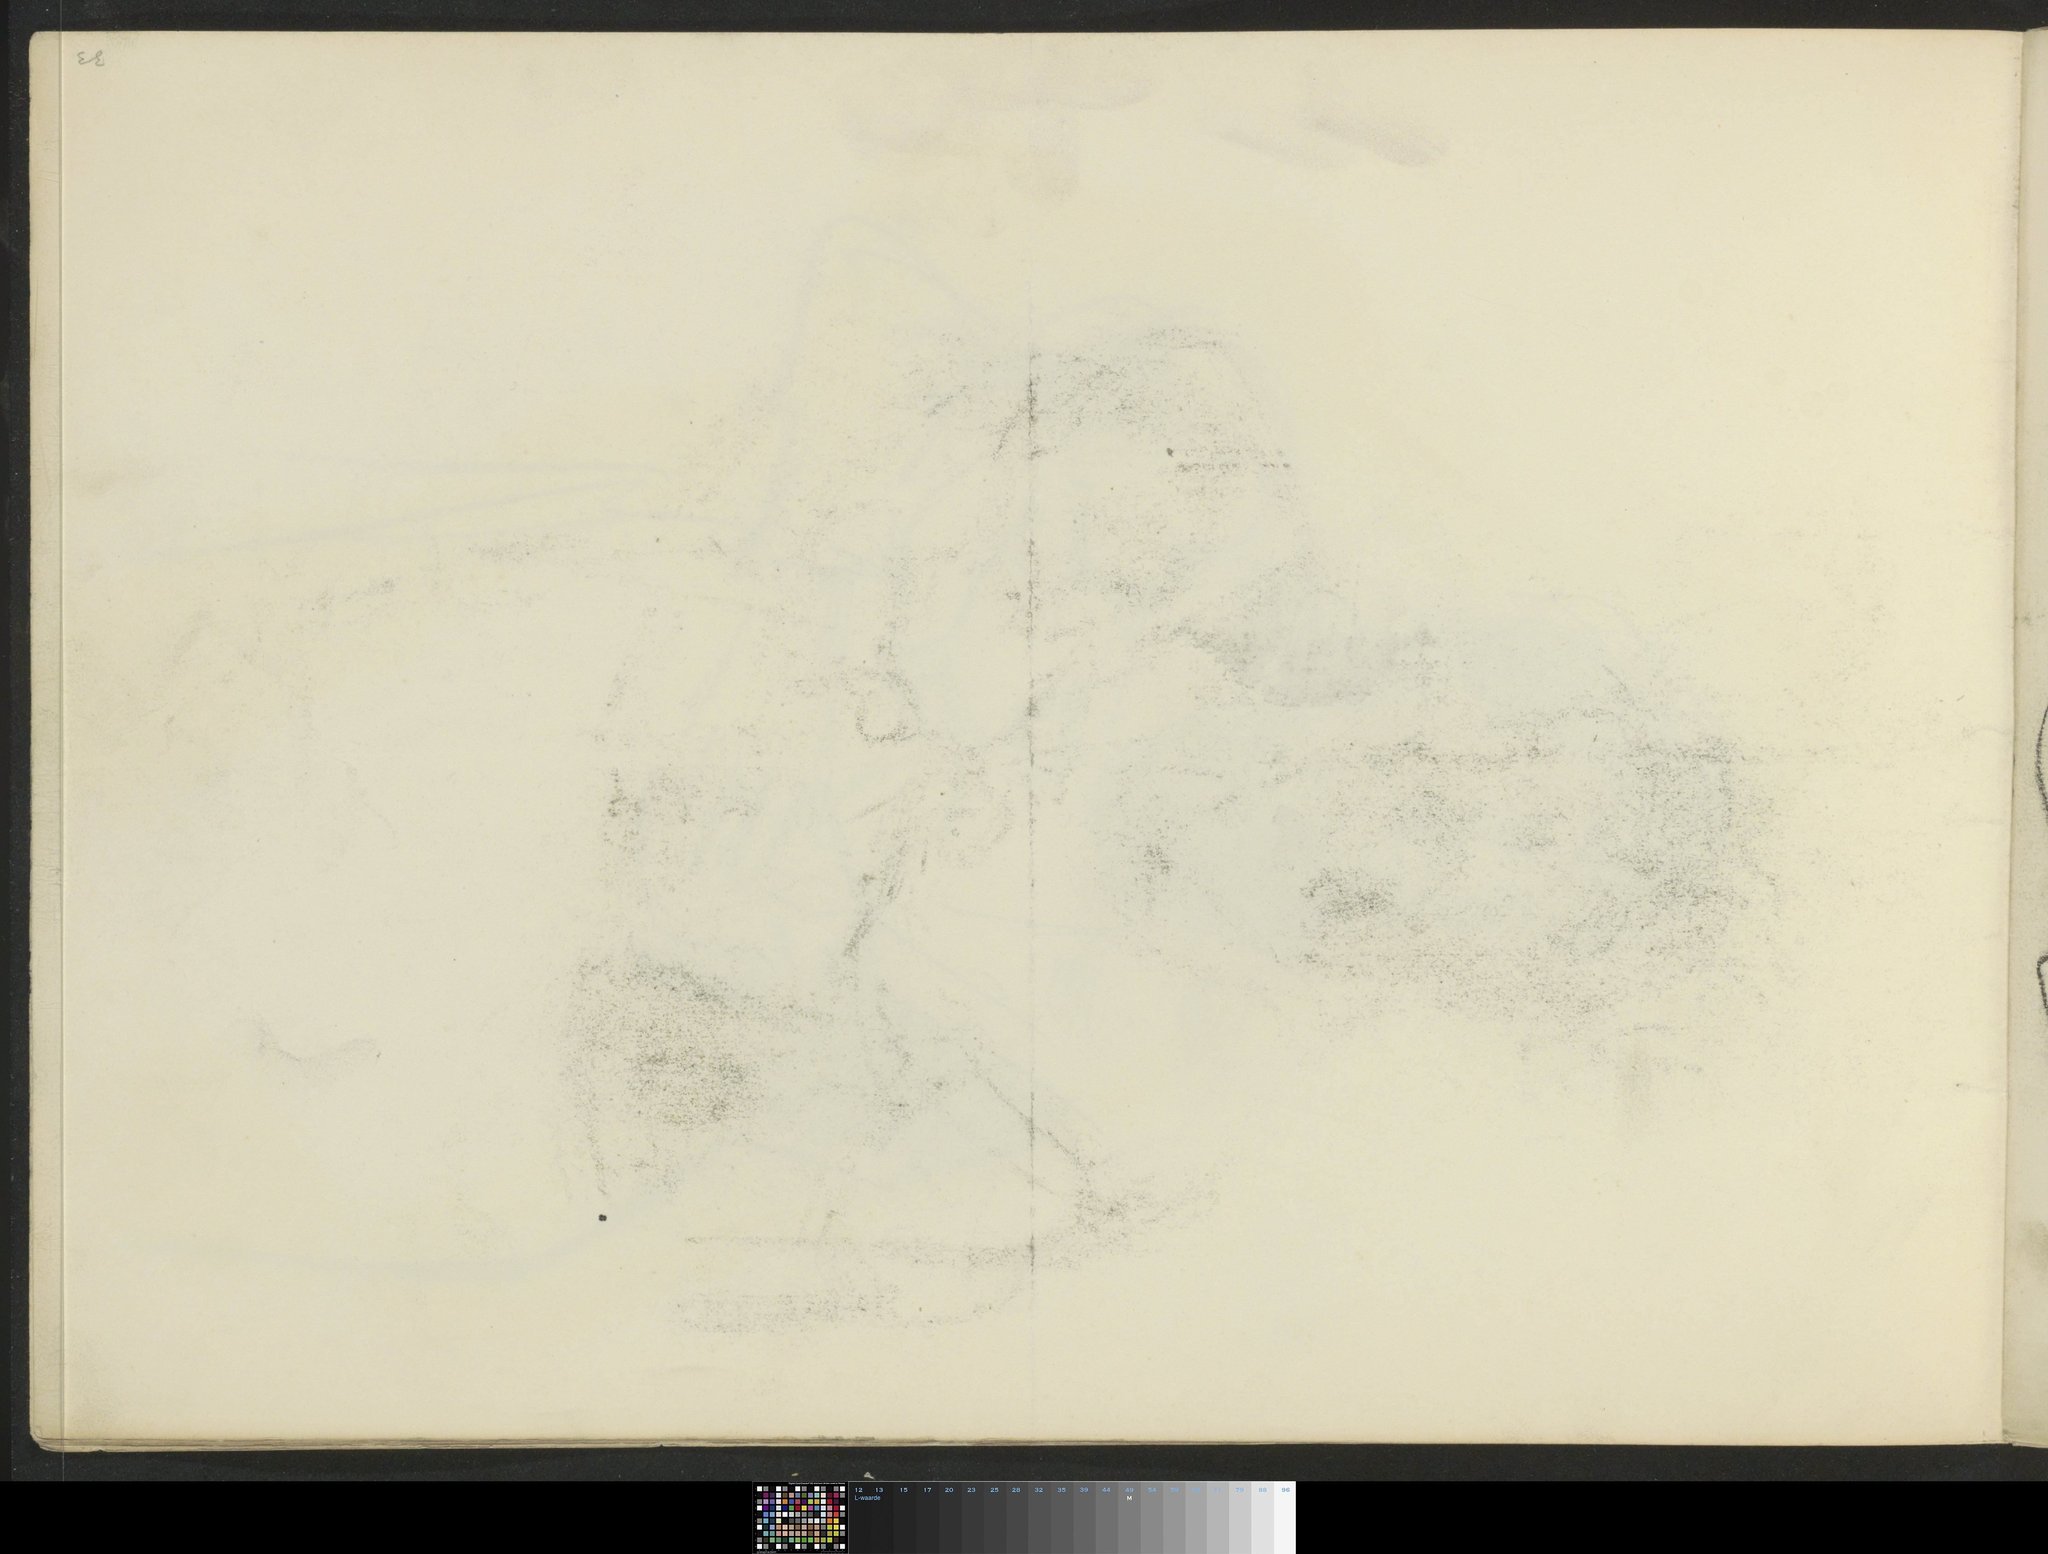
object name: sketchbook leaf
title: Abklatsch van de krijttekening op blad 7 recto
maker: isaac israels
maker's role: draughtsman, painter, print maker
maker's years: 1865-1934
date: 1875-1934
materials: paper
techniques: printmaking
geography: the hague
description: Blad 6 verso uit schetsboek XII met 19 bladen.